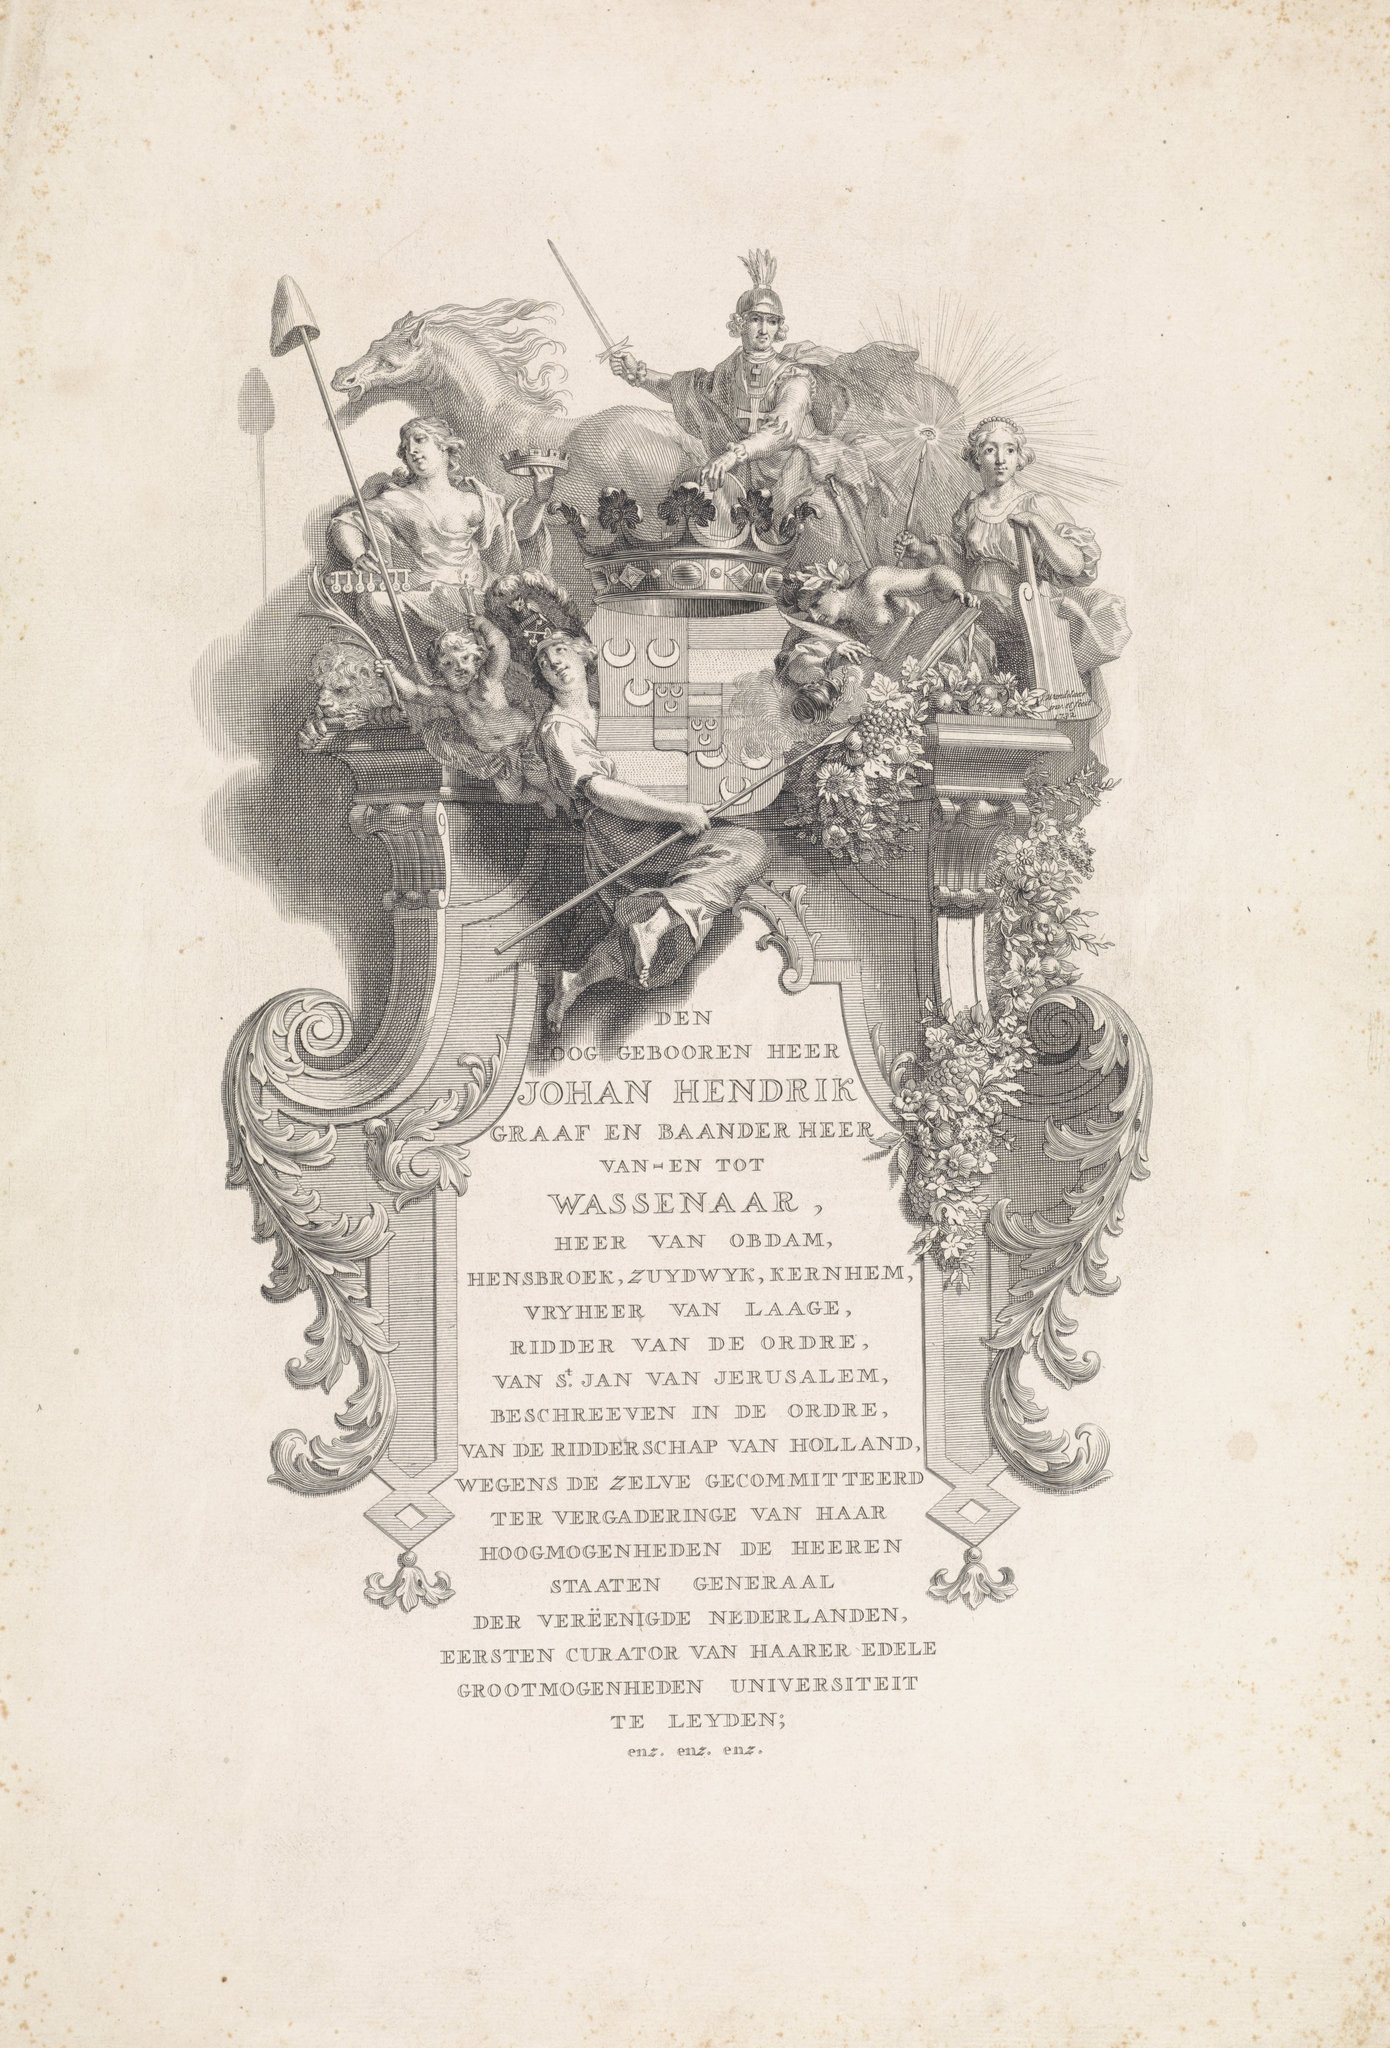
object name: print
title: Ornamentele omlijsting bekroond met het wapenschild van Johan Hendrik van Wassenaer Obdam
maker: jan wandelaar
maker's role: draughtsman, print maker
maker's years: 1690-1759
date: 1732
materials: paper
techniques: engraving, etching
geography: northern netherlands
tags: the hague, personifications of countries, nations, states, districts, etc., (story of) minerva (pallas, athena), 'historia'; 'historia' (ripa), the all-seeing eye, triangle with eye ~ symbol of god the father, knight, armorial bearing, heraldry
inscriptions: collector's mark: Lugt 240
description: Ornamentele omlijsting bekroond met het familiewapen van Wassenaer Obdam, dat door Minerva vastgehouden wordt. Daarboven een ridder met een geheven zwaard in de handen. Links zit de Hollandse Maagd, een lans met vrijheidshoed leunt tegen haar schouder. Voor haar vliegt een putto met een palmtak en een fakkel in de handen. Rechts zit een vrouw met in haar hand een staf met het alziend oog. Voor haar Geschiedenis die naar beneden kijkt. In de omlijsting een opdracht van 22 regels in het Nederlands, aan Johan Hendrik van Wassenaer Obdam, die in 1727 door de Staten van Holland tot curator van de Leidse universiteit werd benoemd.